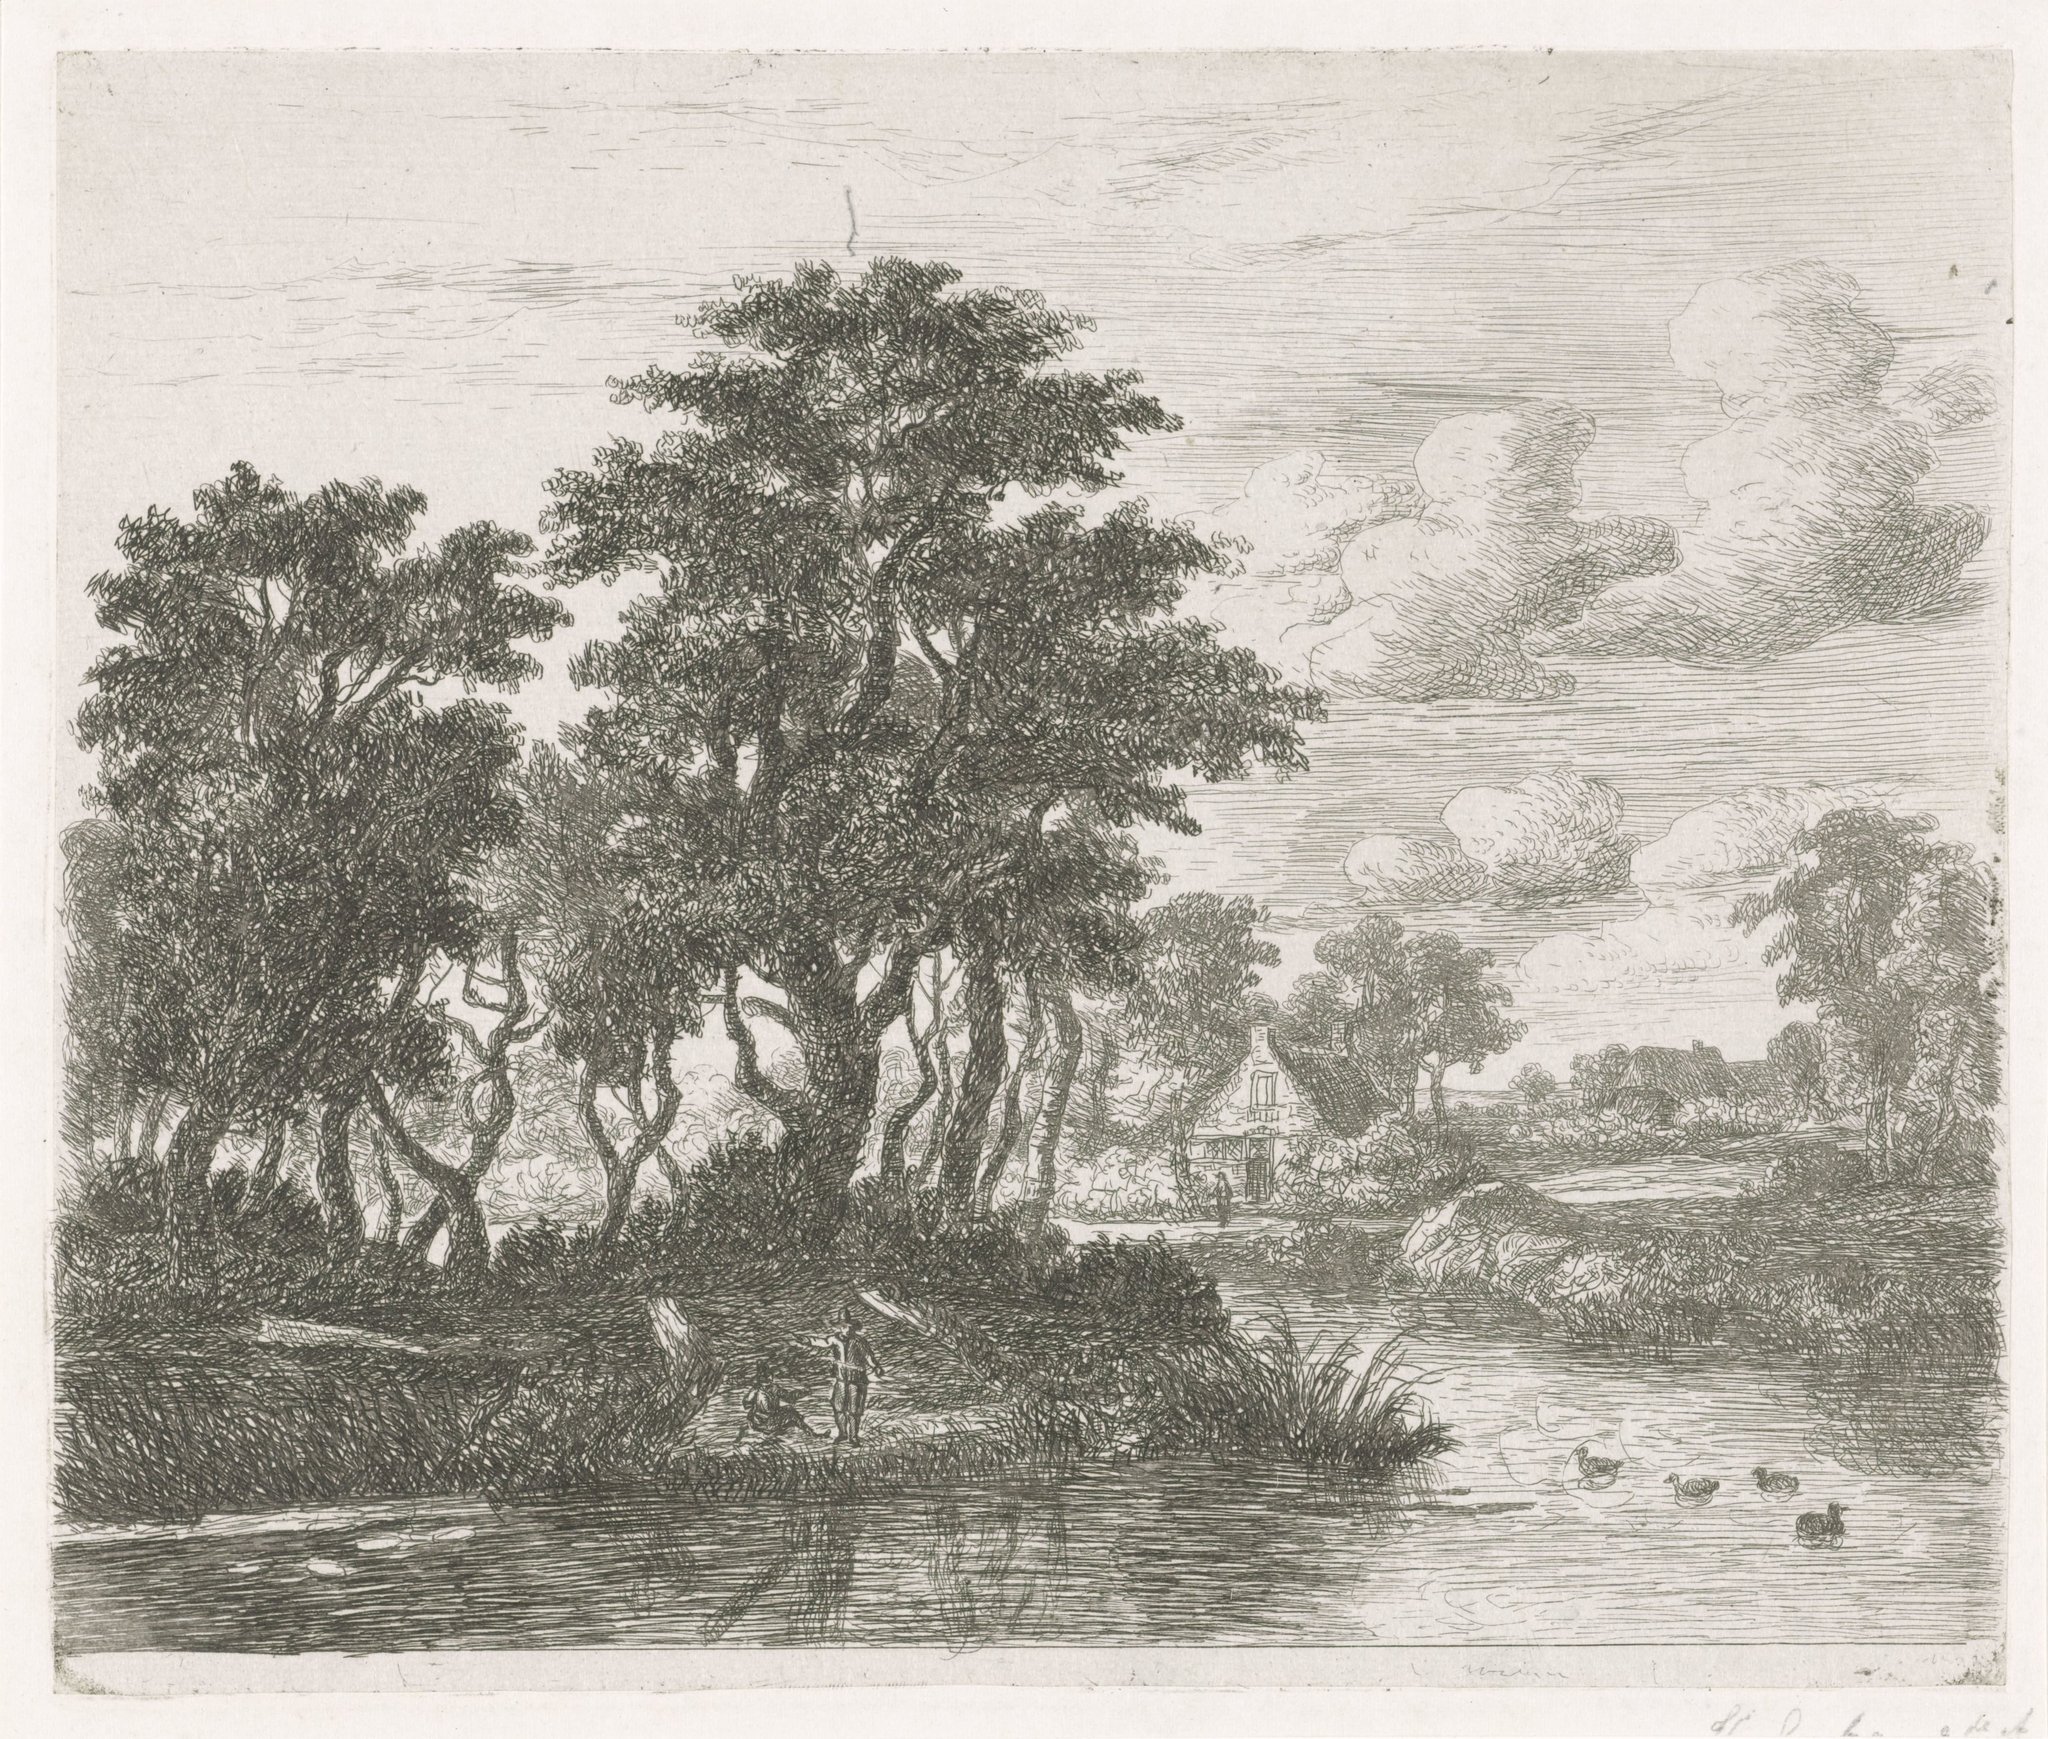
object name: print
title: Rivierlandschap met een hengelaar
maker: hermanus jan hendrik van rijkelijkhuysen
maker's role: painter, print maker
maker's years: 1813-1883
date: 1823-1883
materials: paper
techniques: drypoint, etching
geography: utrecht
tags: trees, river, road, path, water-birds: duck, fisherman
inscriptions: collector's mark: Lugt 2228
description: Een rivier met links een stuk land met hoge bomen, waar zich twee mannen aan de oever van het water bevinden. Een van hen heeft zijn hengel uitgegooid. Rechts aan de overkant loopt een landweg waaraan enige huizen liggen. Op de voorgrond vier eenden.